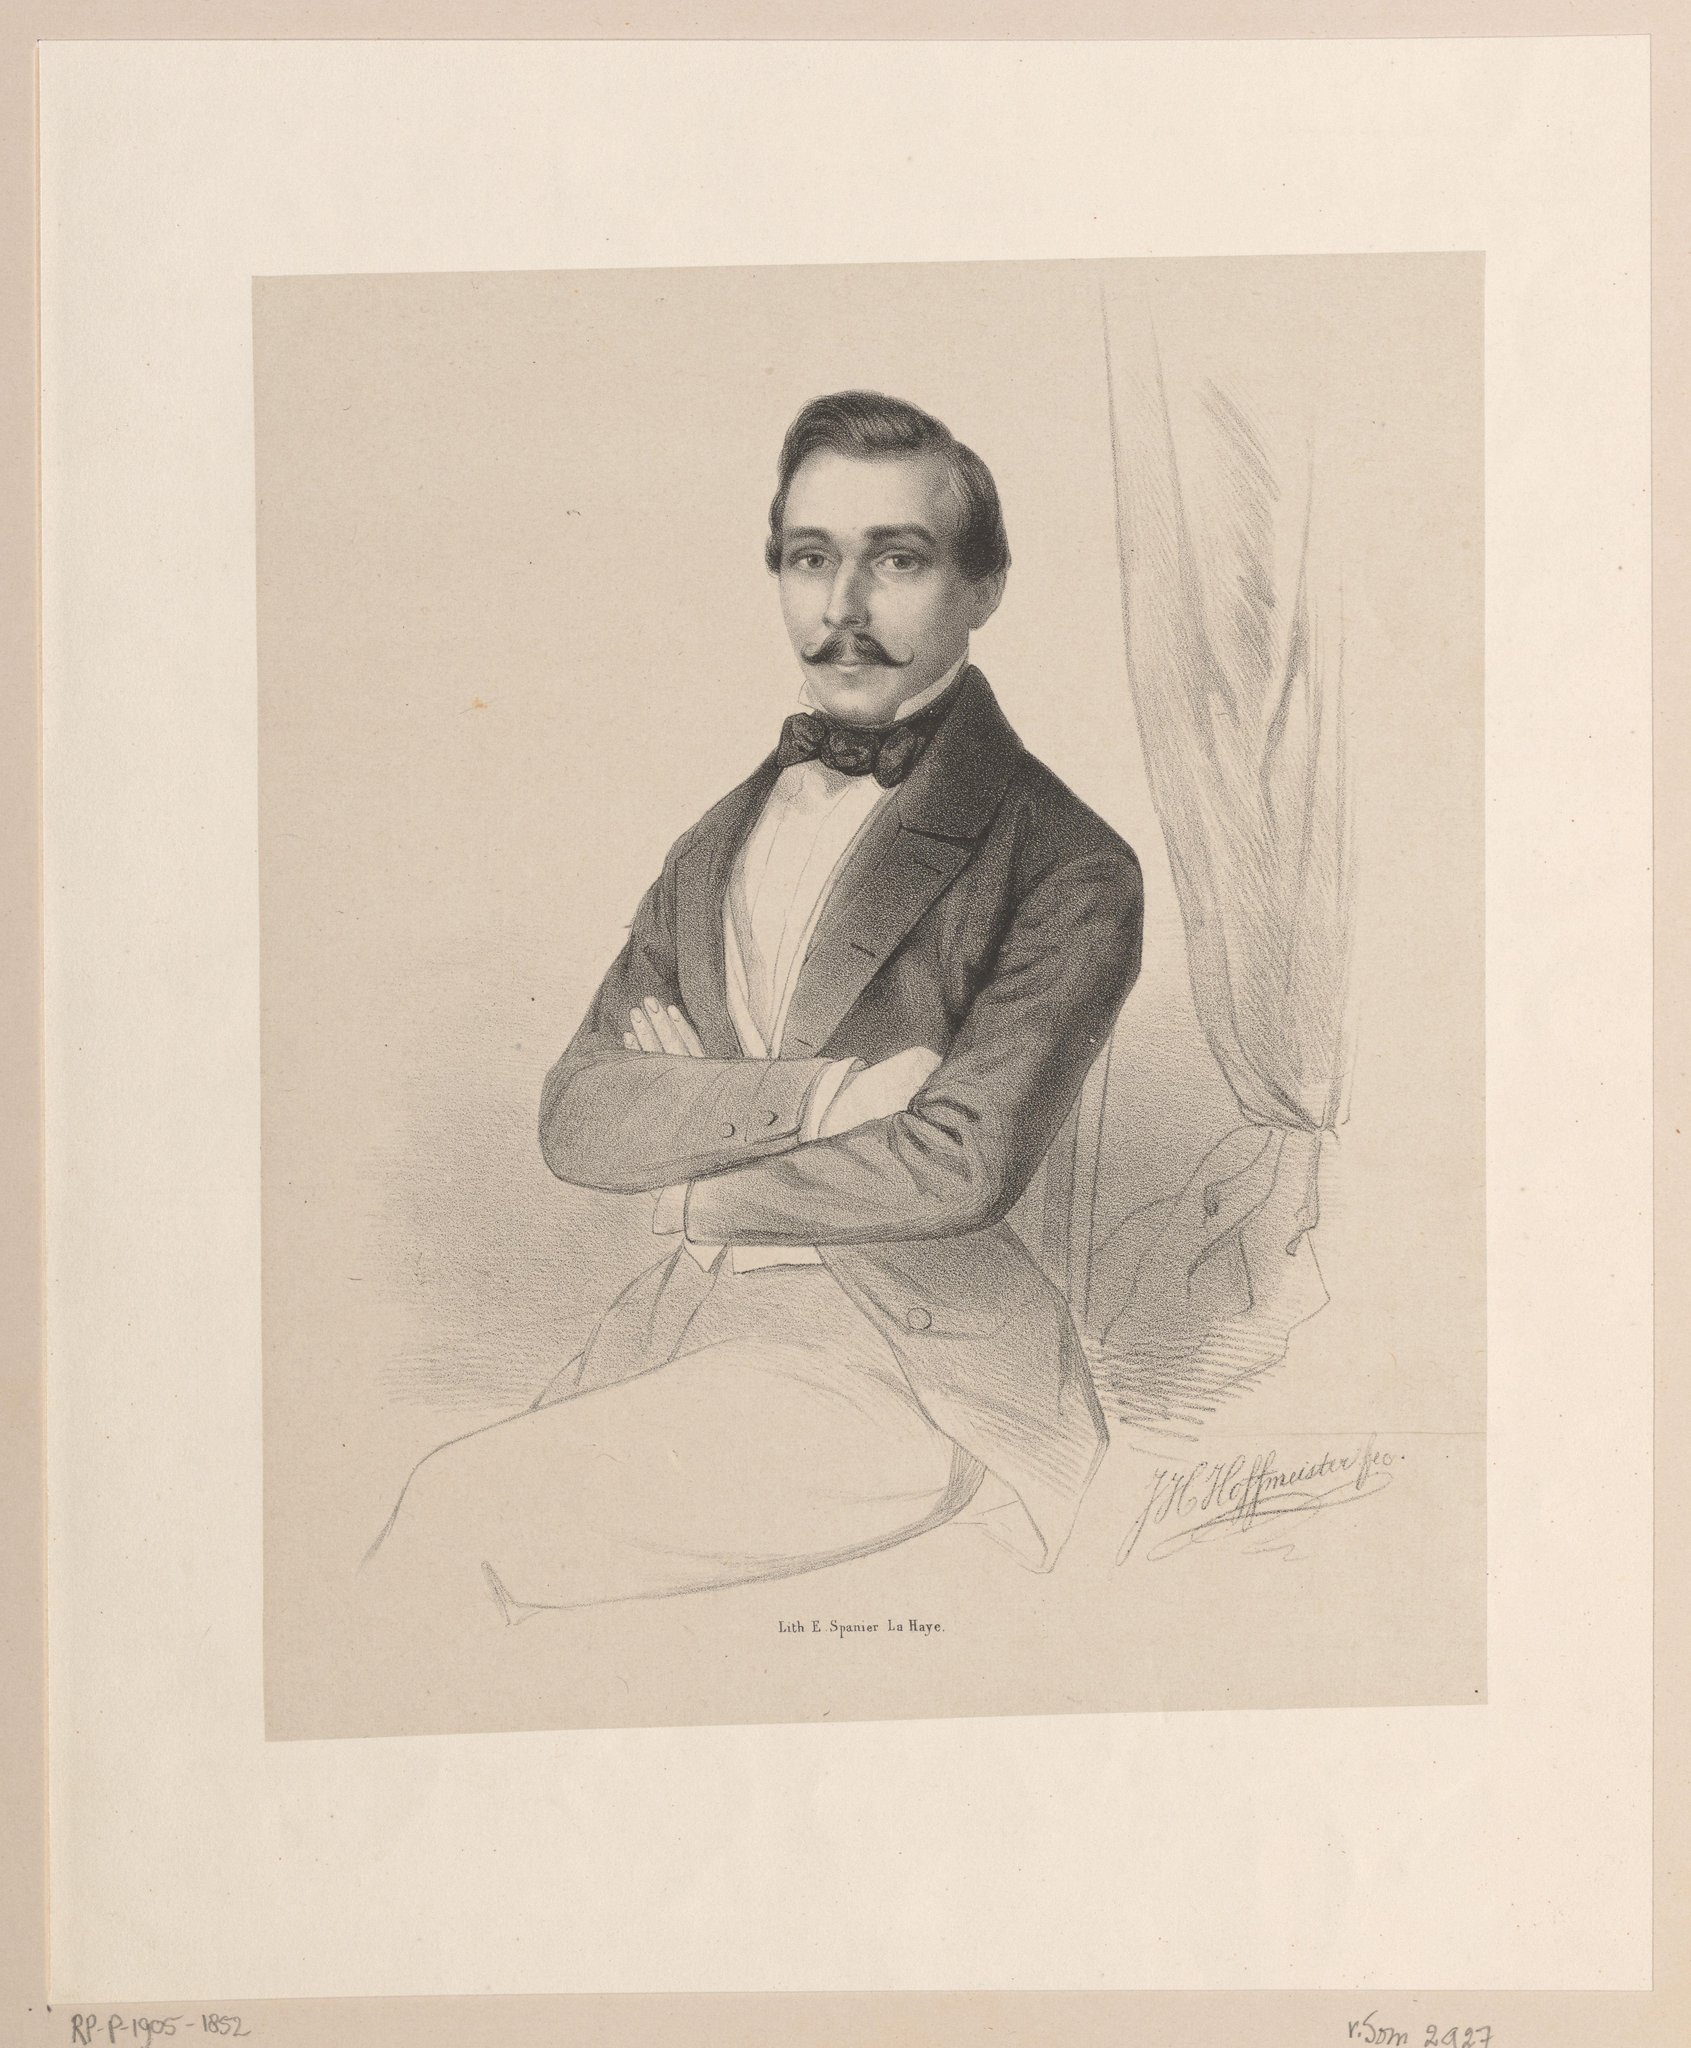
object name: print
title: Portret van Levinus Wilhelmus Christiaan Keuchenius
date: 1843-1863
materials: paper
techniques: lithograph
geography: the hague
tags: batavia, the hague, historical persons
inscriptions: collector's mark: Lugt 2228